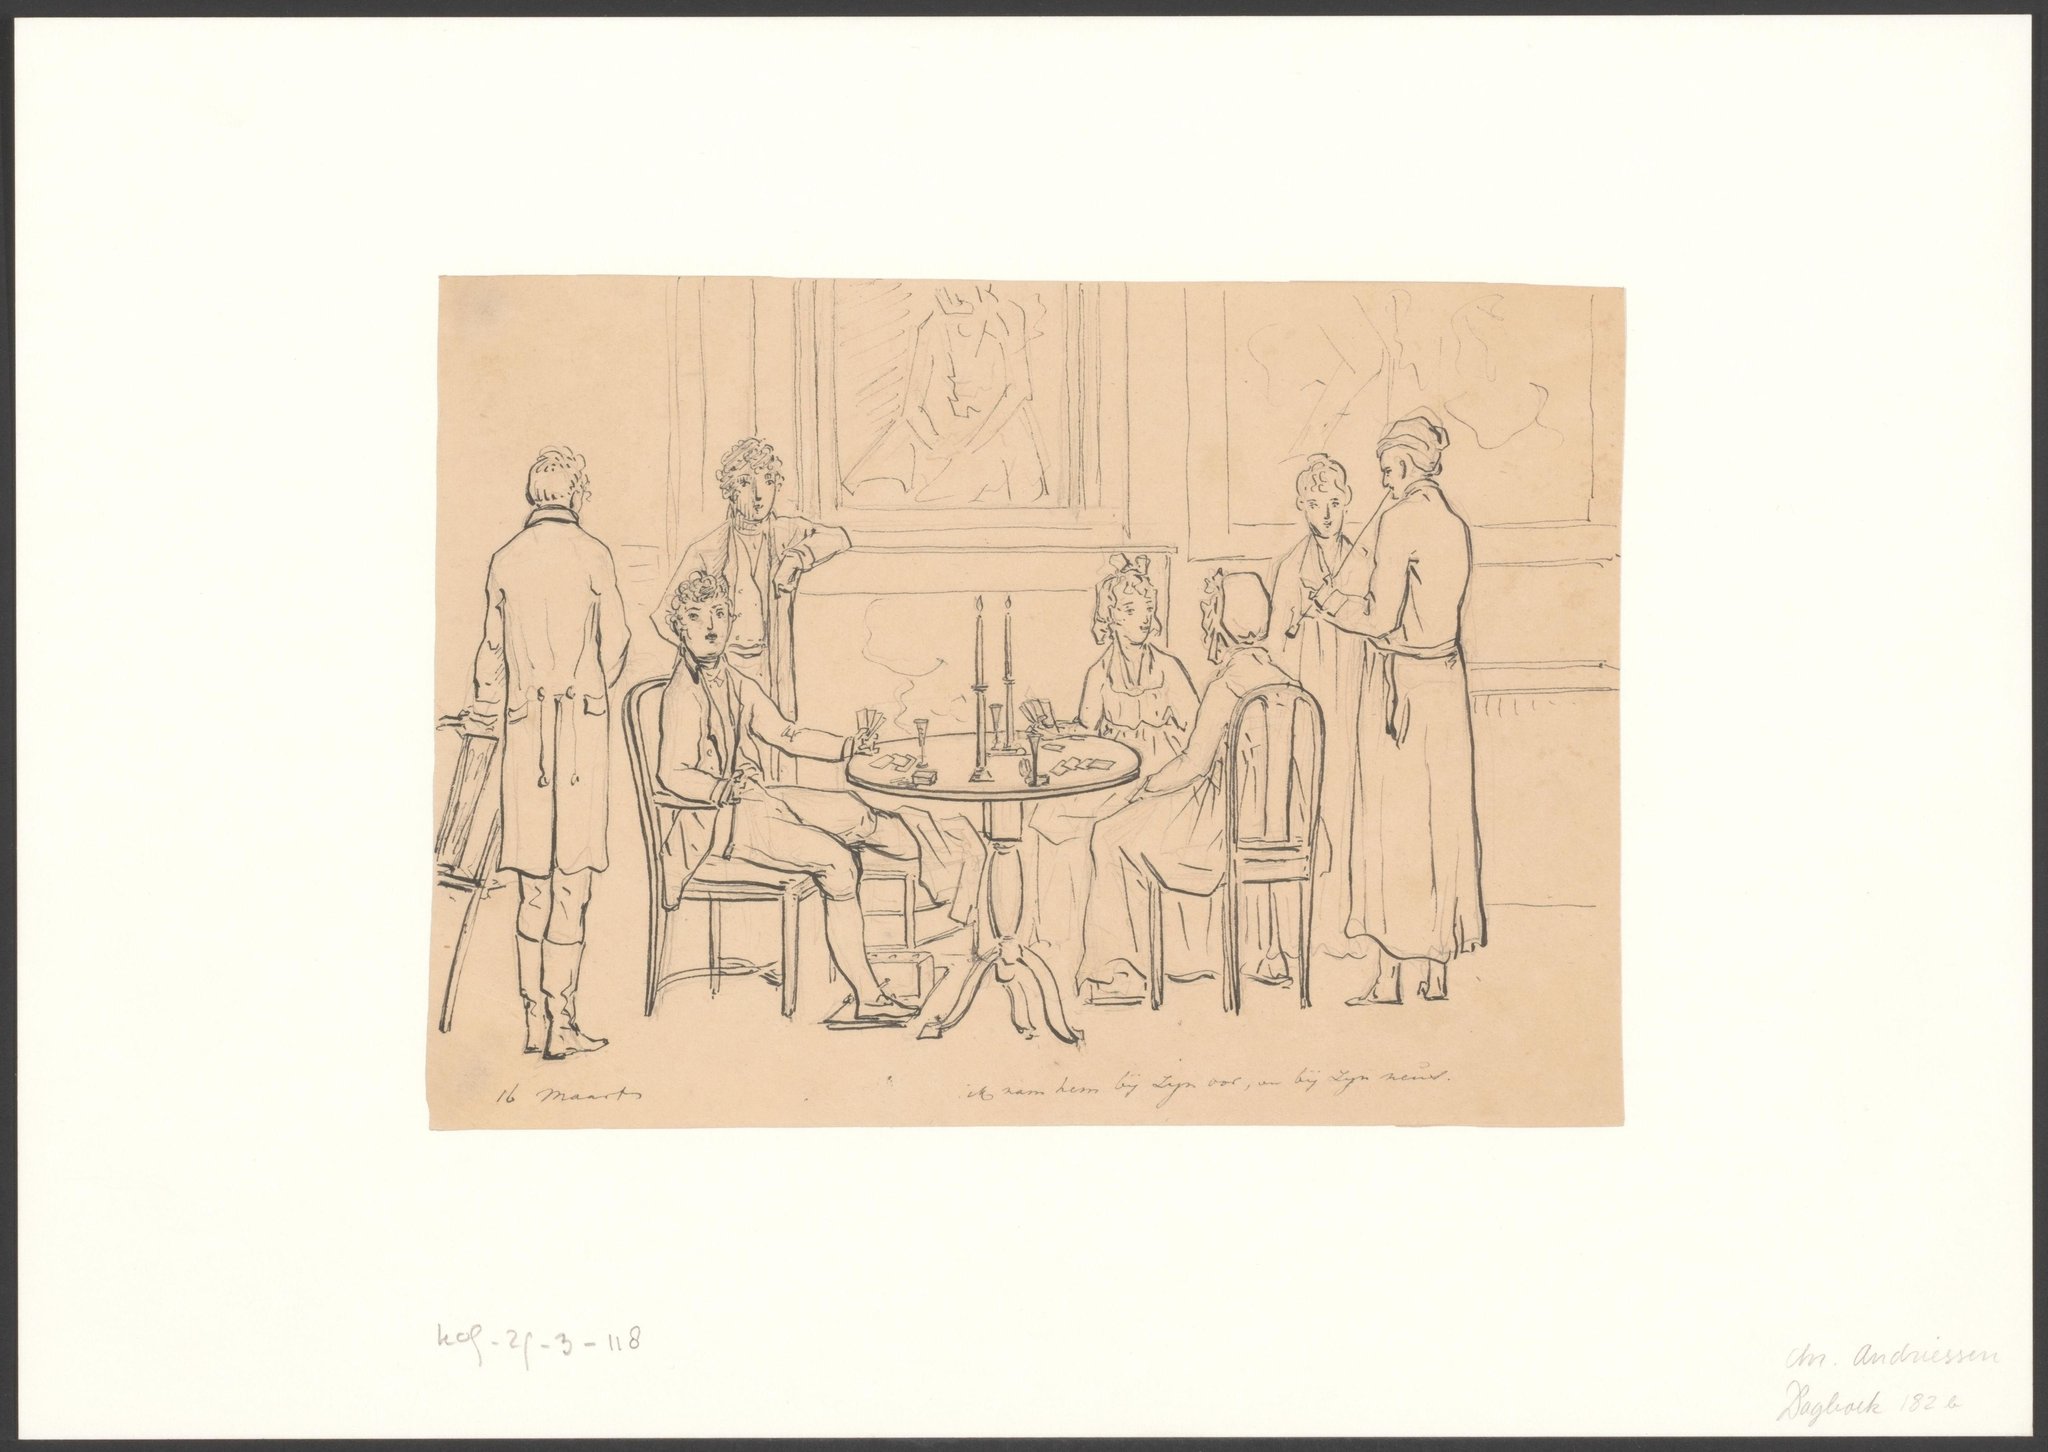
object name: drawing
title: Jong gezelschap speelt een kaartspel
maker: christiaan andriessen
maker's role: draughtsman, print maker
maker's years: 1775-1846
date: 1805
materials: ink, paper, pencil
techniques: pen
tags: card games, private festivities, merry company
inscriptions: signature: ‘J Andriessen’, inscription: ‘16 maart ik nam hem bij zijn oor, en bij zijn neus’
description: Dagboekblad uit het getekende dagboek dat Christiaan Andriessen bijhield van 1805 tot en met 1808.